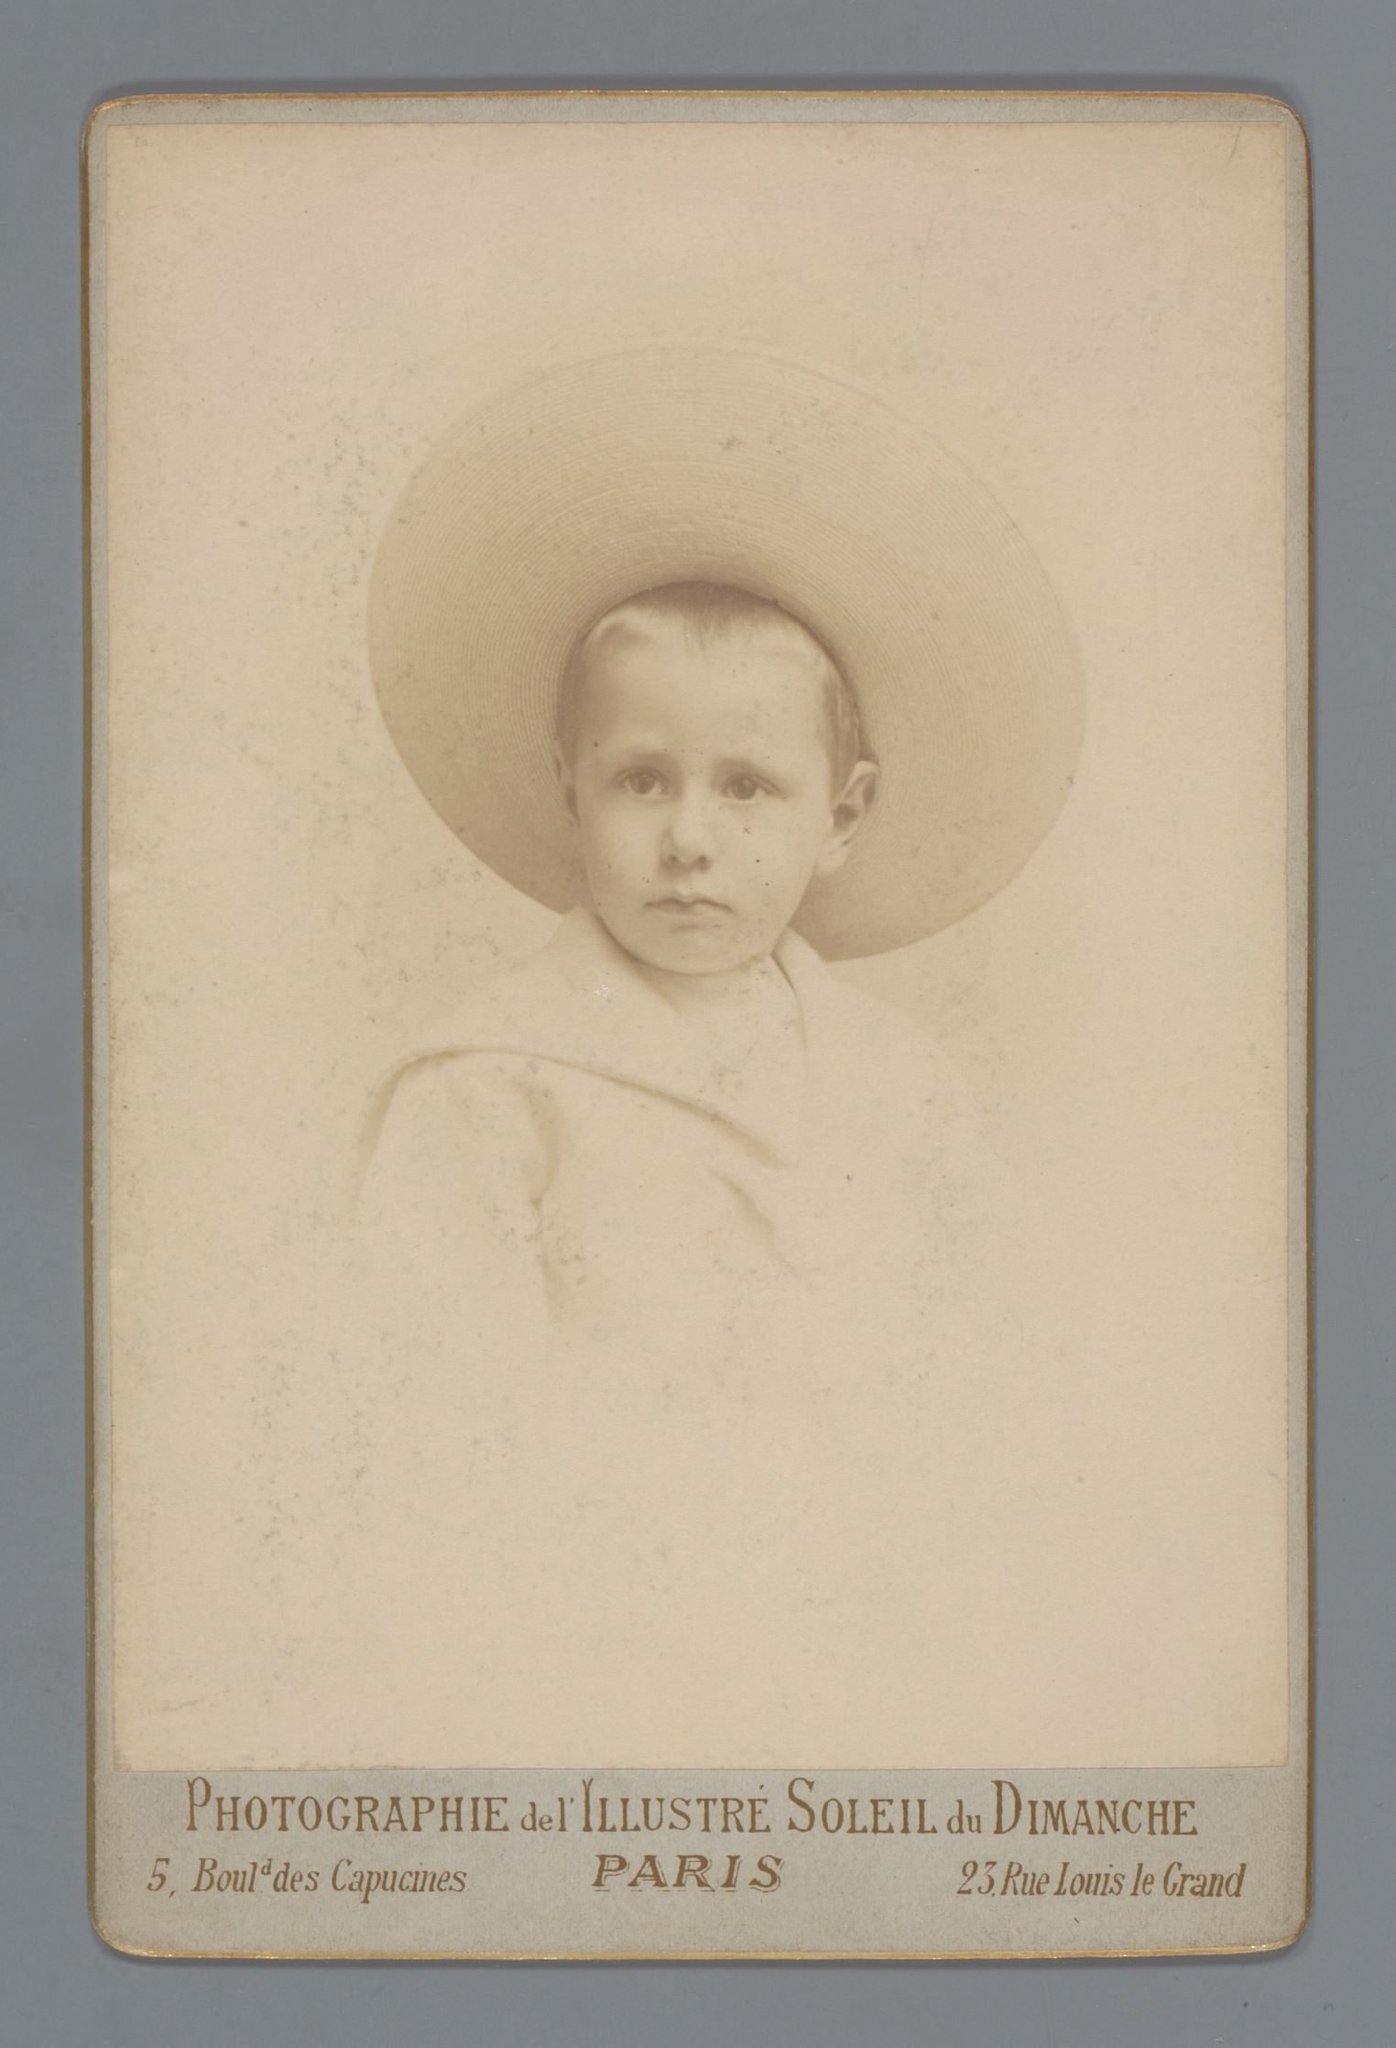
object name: cabinet photograph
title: Portret van een onbekende jongen met een zonnehoed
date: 1870-1895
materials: cardboard, photographic support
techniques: albumen print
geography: paris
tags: boy (child between toddler and youth), head-gear: hat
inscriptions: name: ‘Photographie de l'Illustre Soleil du Dimanche 5, Bould des Capucines Paris 23 Rue Louis le Grand’, name: ‘Photographie de l'Illustre Soleil du Dimanche Entrées des Salons et des Ateliers 5, Bould des Capucines Paris 23 Rue Louis le Grand (...) prix.’